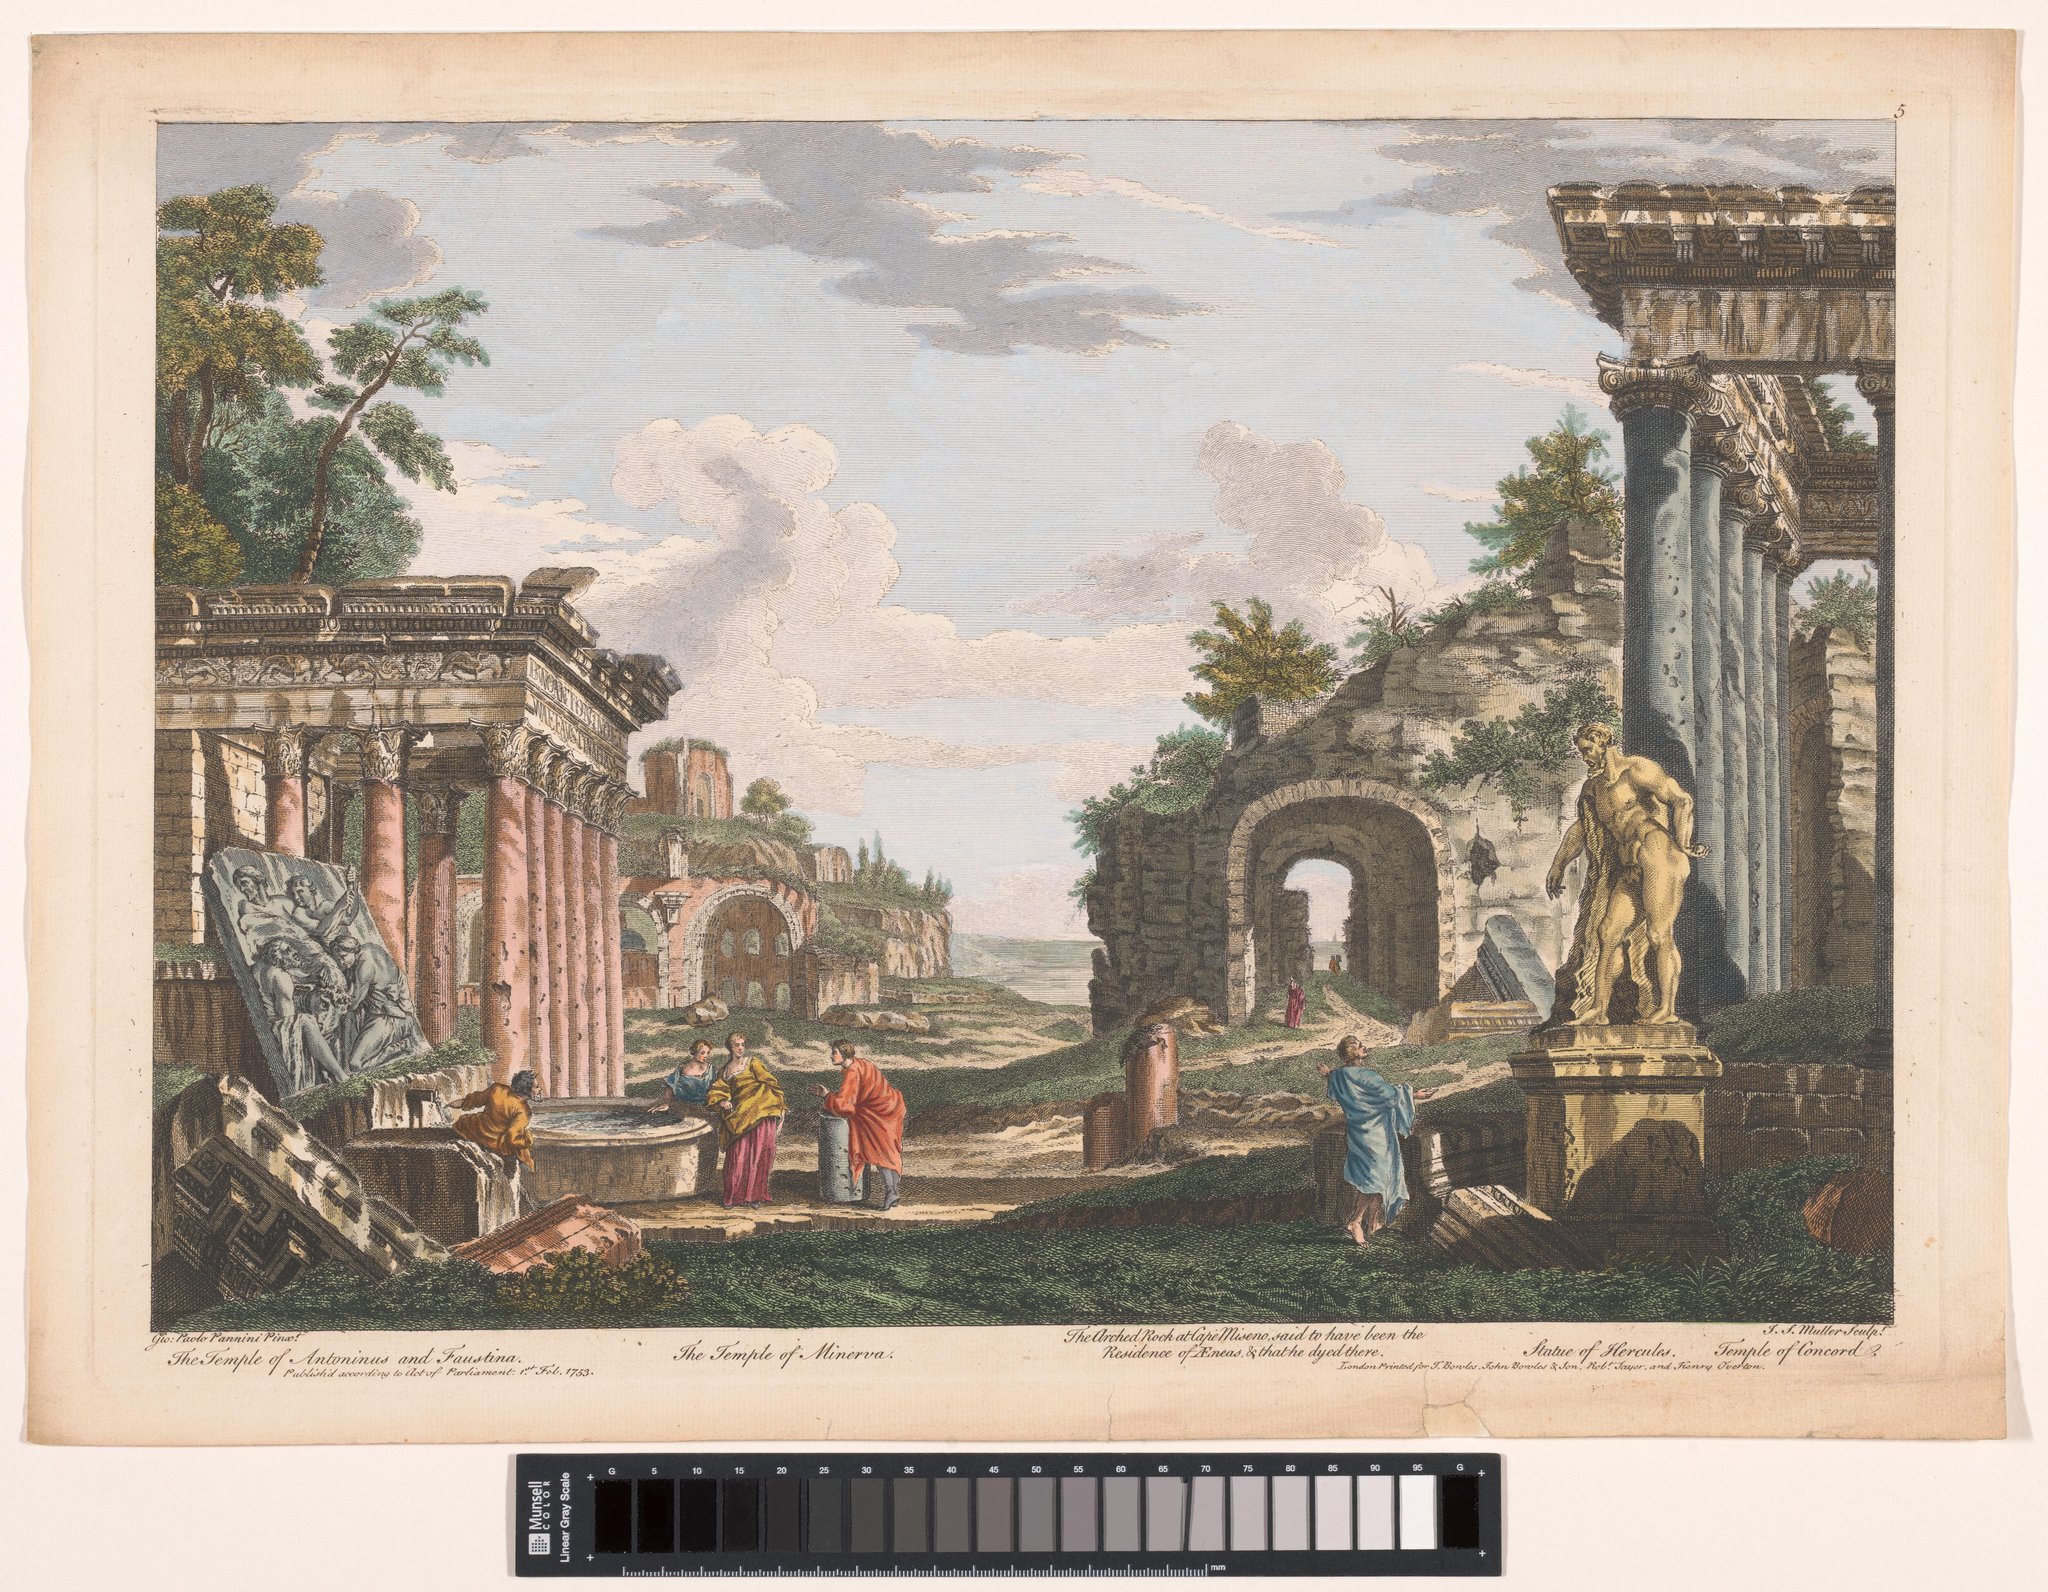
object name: opticaprent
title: Romeinse oudheid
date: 1753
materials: paper, watercolor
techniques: brush, etching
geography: london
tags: temple, shrine ~ roman religion, sculpture, landscape with ruins (+ city(-scape) with figures, staffage)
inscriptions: watermark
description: Bij de brokstukken staan figuren. In de ondermarge regels Engelse tekst. Rechtsboven genummerd: 5.